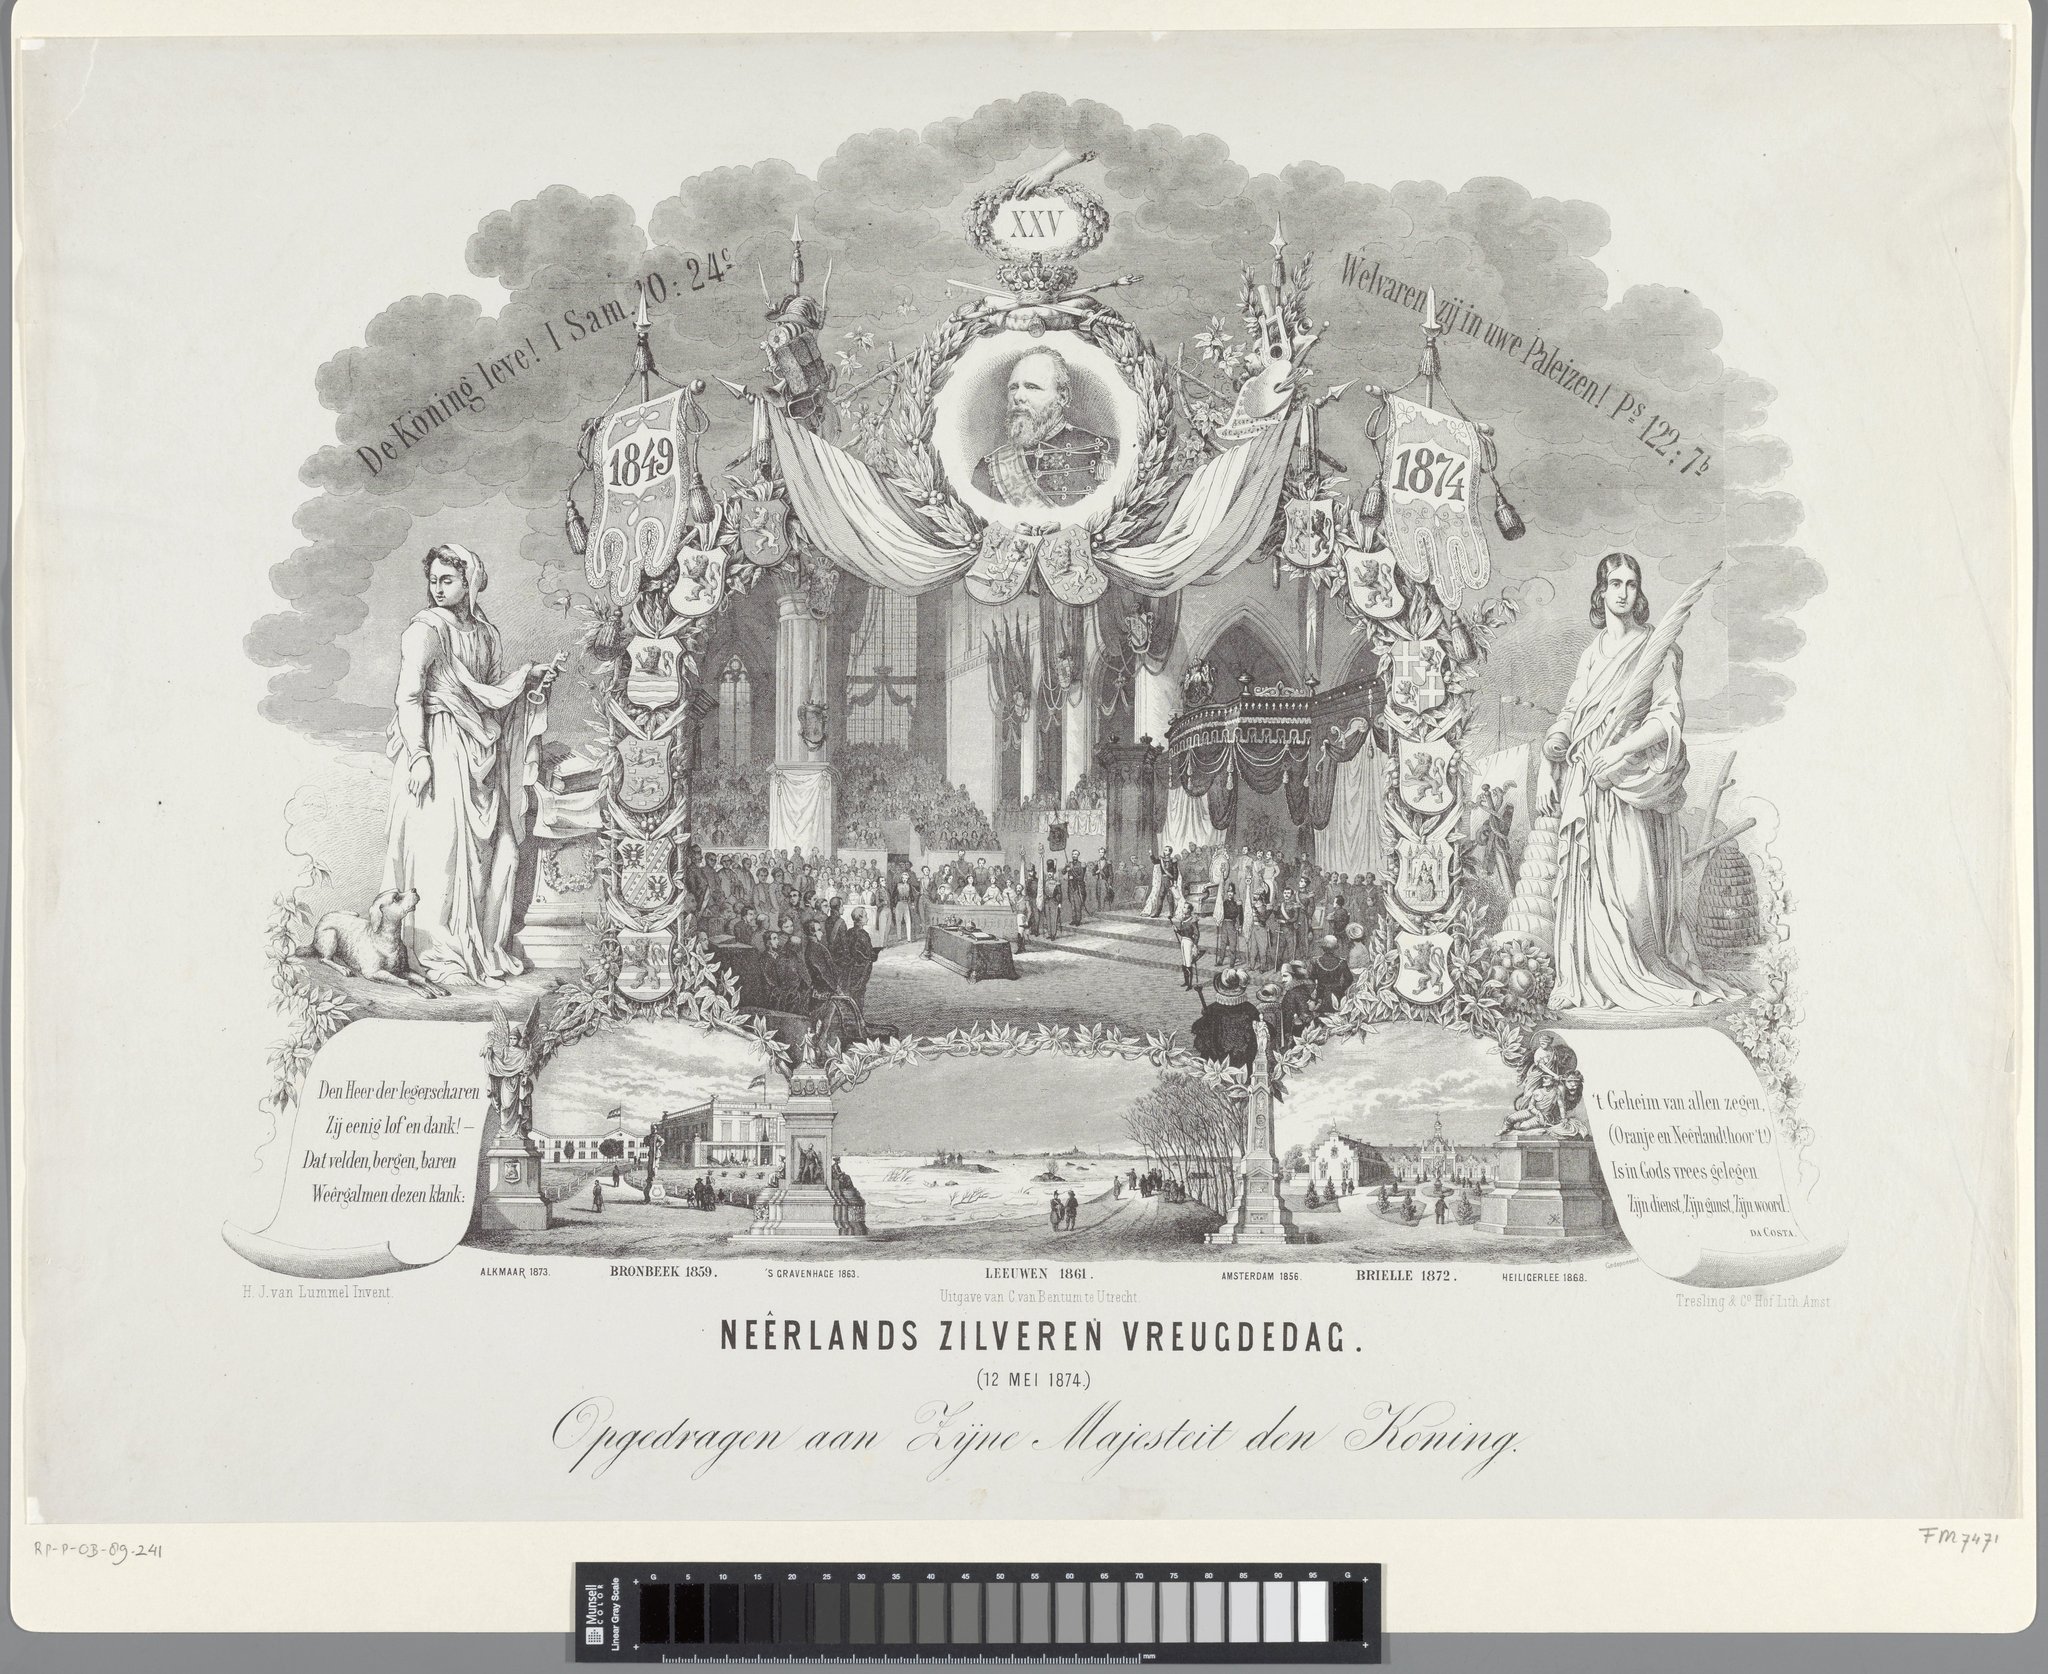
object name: print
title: Neêrlands Zilveren Vreugdedag. (12 Mei 1874.)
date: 1874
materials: paper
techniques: lithograph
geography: netherlands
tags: brussels, willem iii (koning der nederlanden), new ruler taking the oath, brielle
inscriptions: collector's mark: Lugt 2228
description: Gedenkplaat bij de viering van het 25-jarige regeringsjubileum van koning Willem III, 12 mei 1874. Centraal de inhuldiging van koning Willem III in de Nieuwe Kerk te Amsterdam op 12 mei 1849. Aan weerszijden allegorische vrouwenfiguren. Onderaan drie scènes: Bronbeek gesticht door de koning in 1859, het bezoek van de koning aan het door watersnood getroffen Leeuwen in 1861 en het in 1872 opgerichte Zeemanshuis te Brielle. Tussen deze scènes de monumenten opgericht te Alkmaar in 1873, 's-Gravenhage 1863, Amsterdam 1856 en Heiligerlee 1868. Bovenaan een portret van Willem III. Met verschillende Bijbelcitaten en andere verzen.